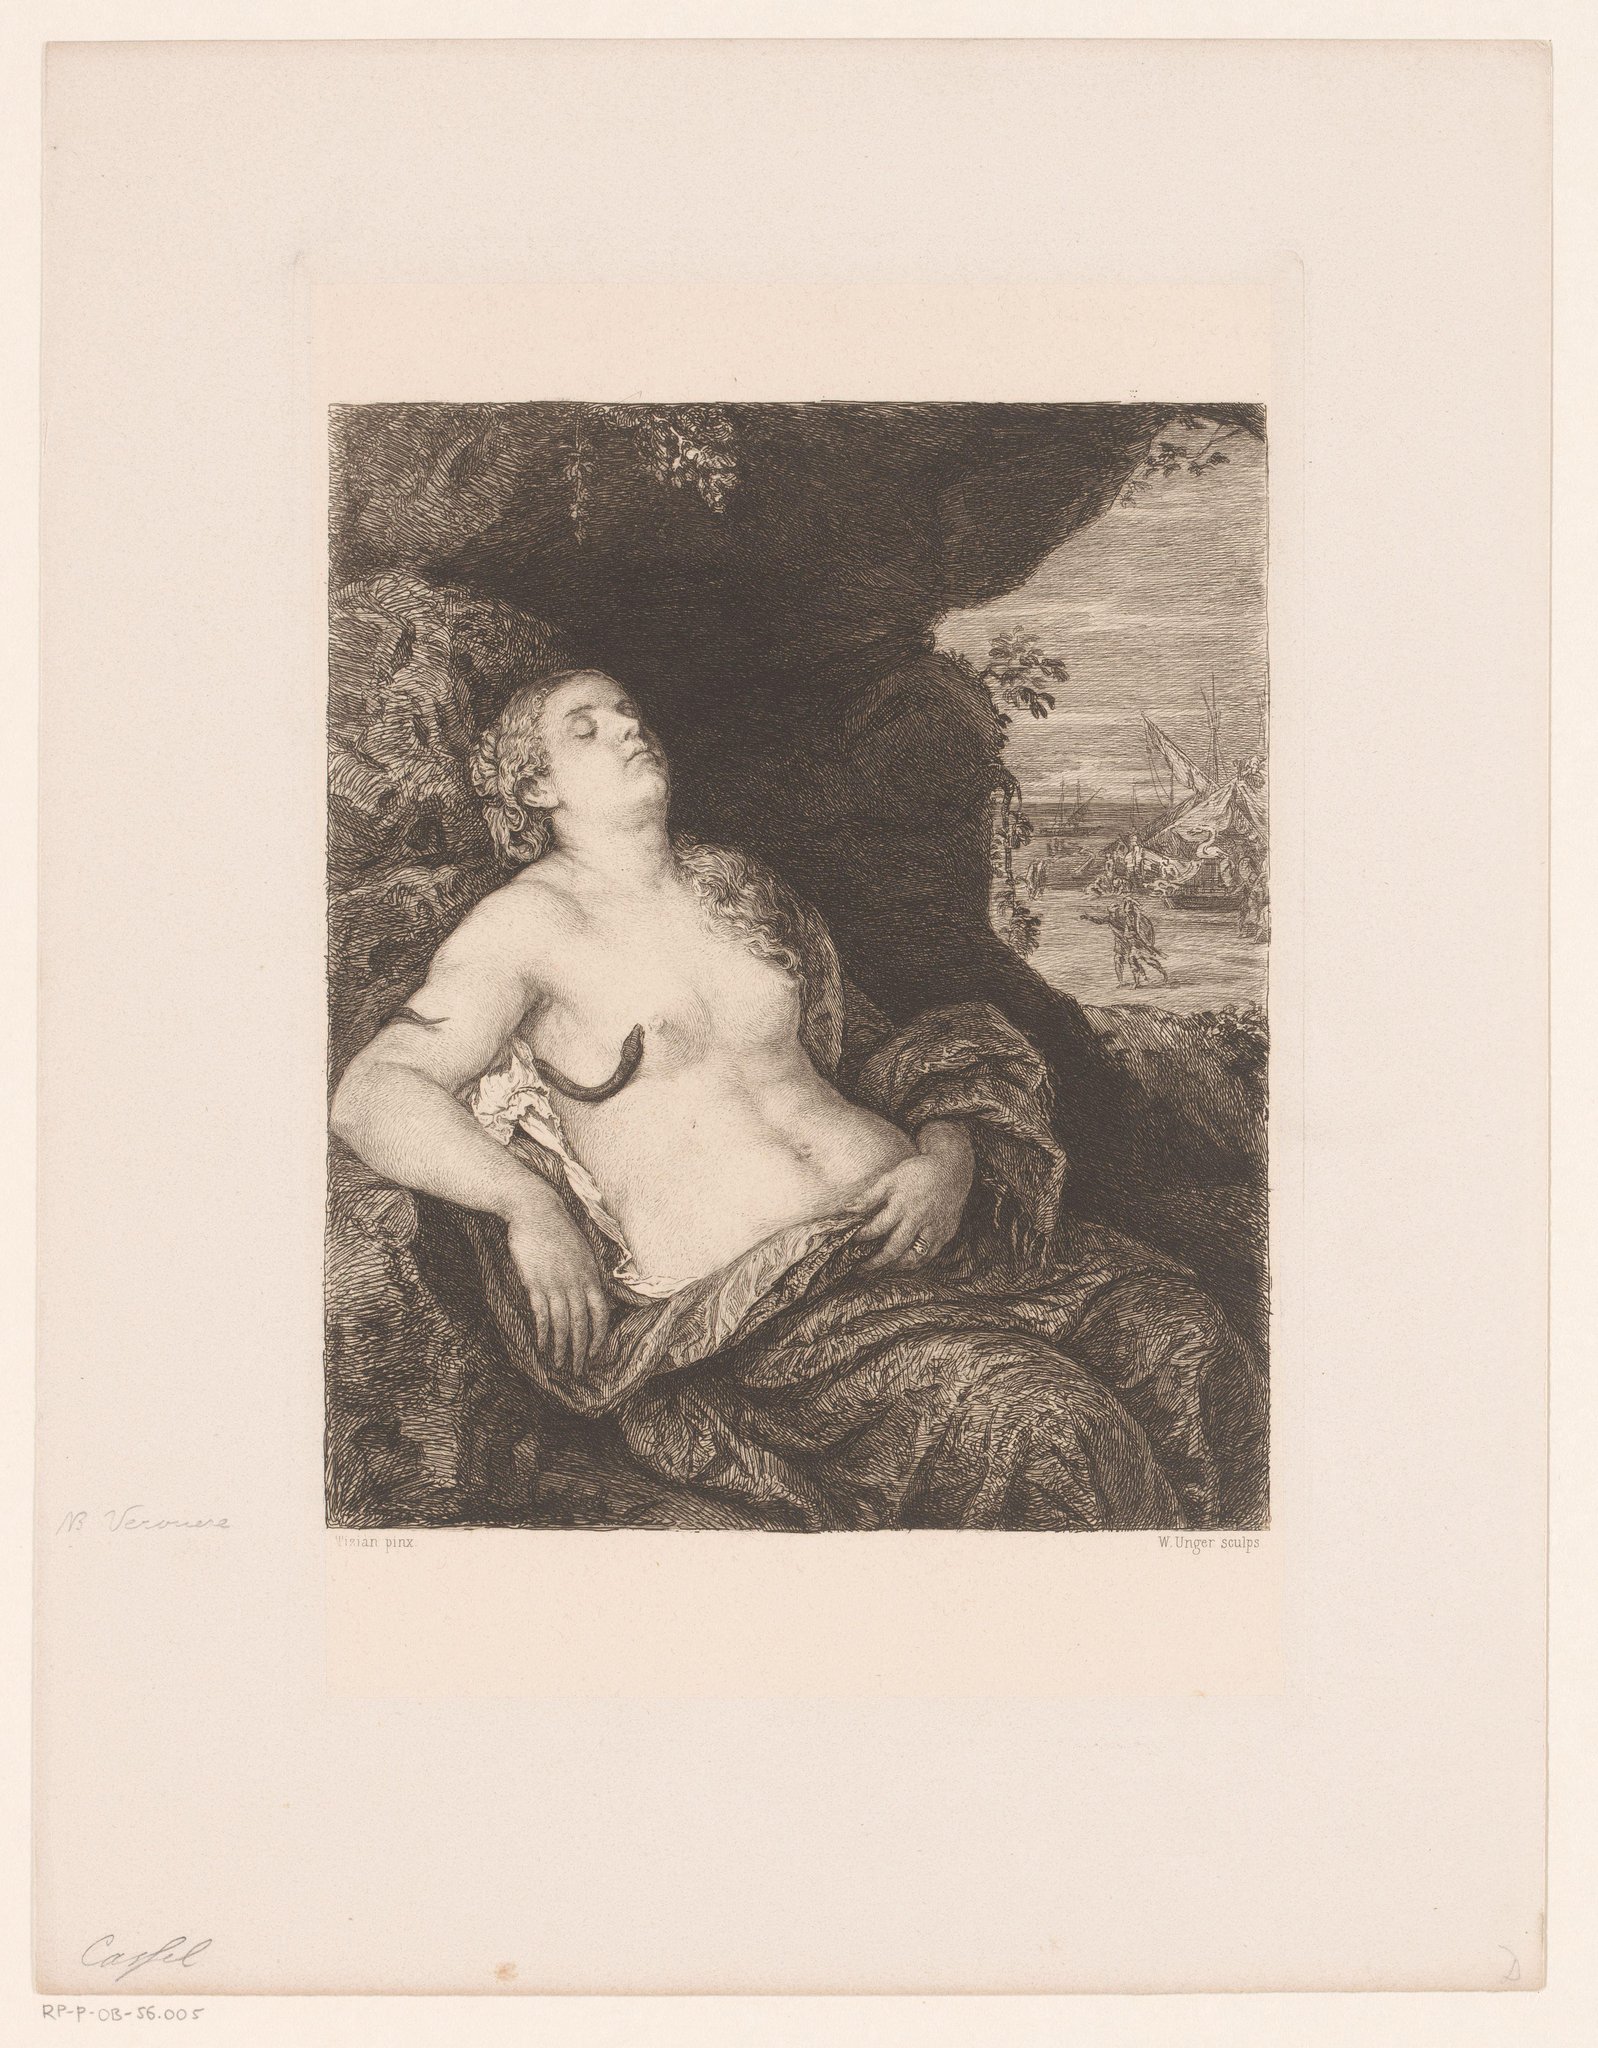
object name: print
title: Dood van Cleopatra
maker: william unger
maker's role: draughtsman, painter, print maker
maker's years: 1837-1932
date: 1847-1889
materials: paper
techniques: etching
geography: germany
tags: sailing-ship, sailing-boat, death of cleopatra: she commits suicide by holding to her breast an asp, which she has taken from a basket of figs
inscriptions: collector's mark: Lugt 2228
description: Prent naar het schilderij door Lambert Sustris in de Gemäldegalerie Alte Meister te Kassel (inv.nr. GK 504).